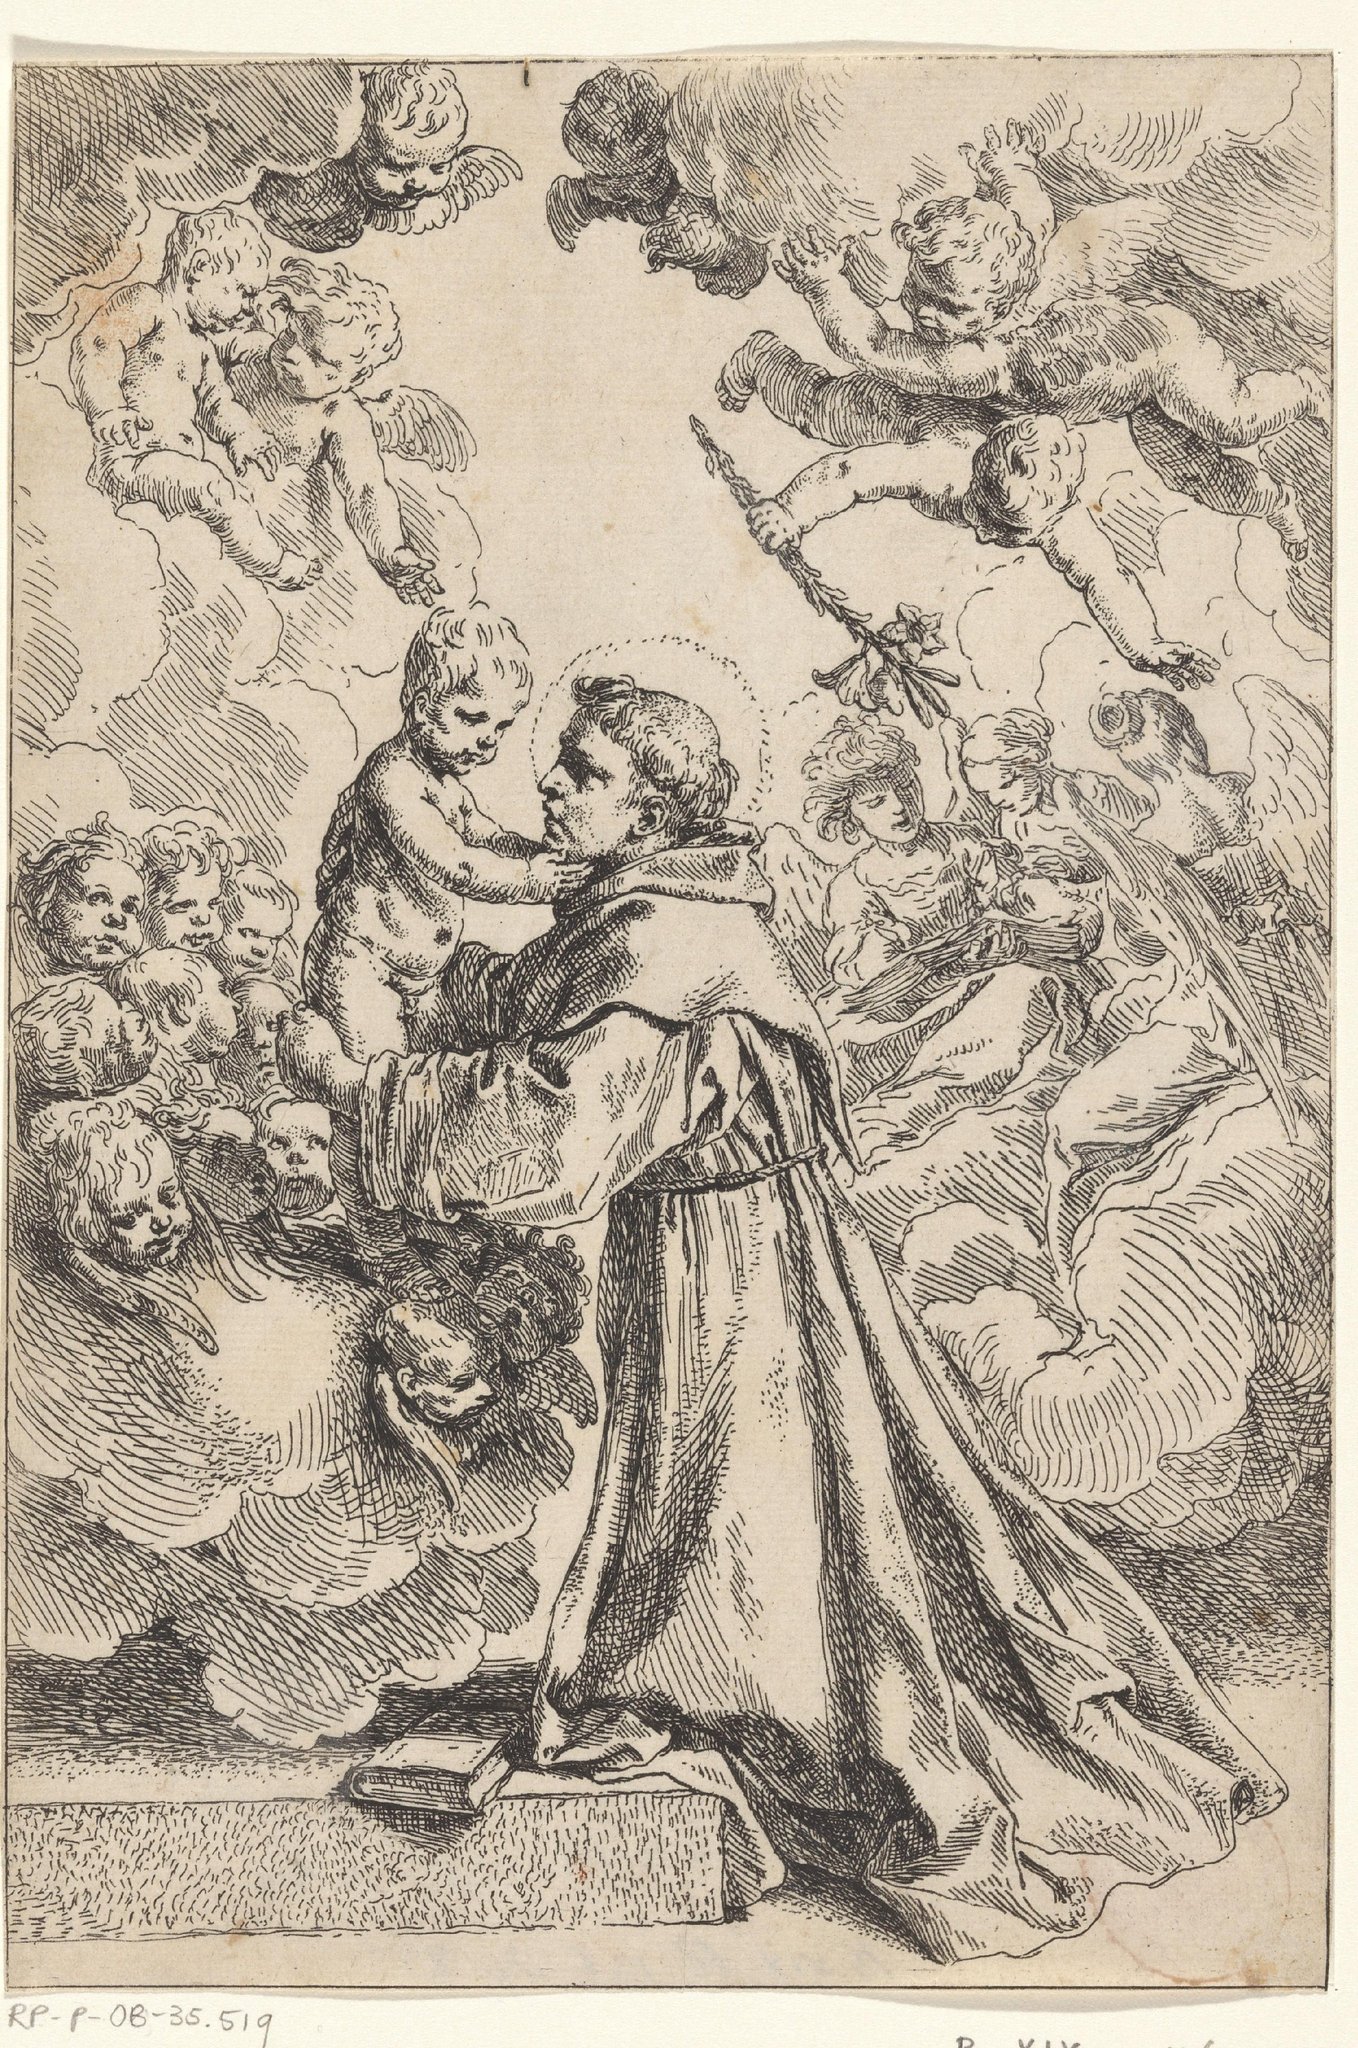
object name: print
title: Heilige Antonius van Padua aanbidt het Christuskind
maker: simone cantarini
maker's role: draughtsman, print maker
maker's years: 1612-1648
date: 1622-1648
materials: paper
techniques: etching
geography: italy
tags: the franciscan monk antony of padua; possible attributes: ass, book, crucifix, flowered cross, flaming heart, infant christ (on book), lily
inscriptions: collector's mark: Lugt 240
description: De Heilige Antonius van Padua zit geknield voor het Christuskind. Ze worden omringd door cherubijnen en putti.